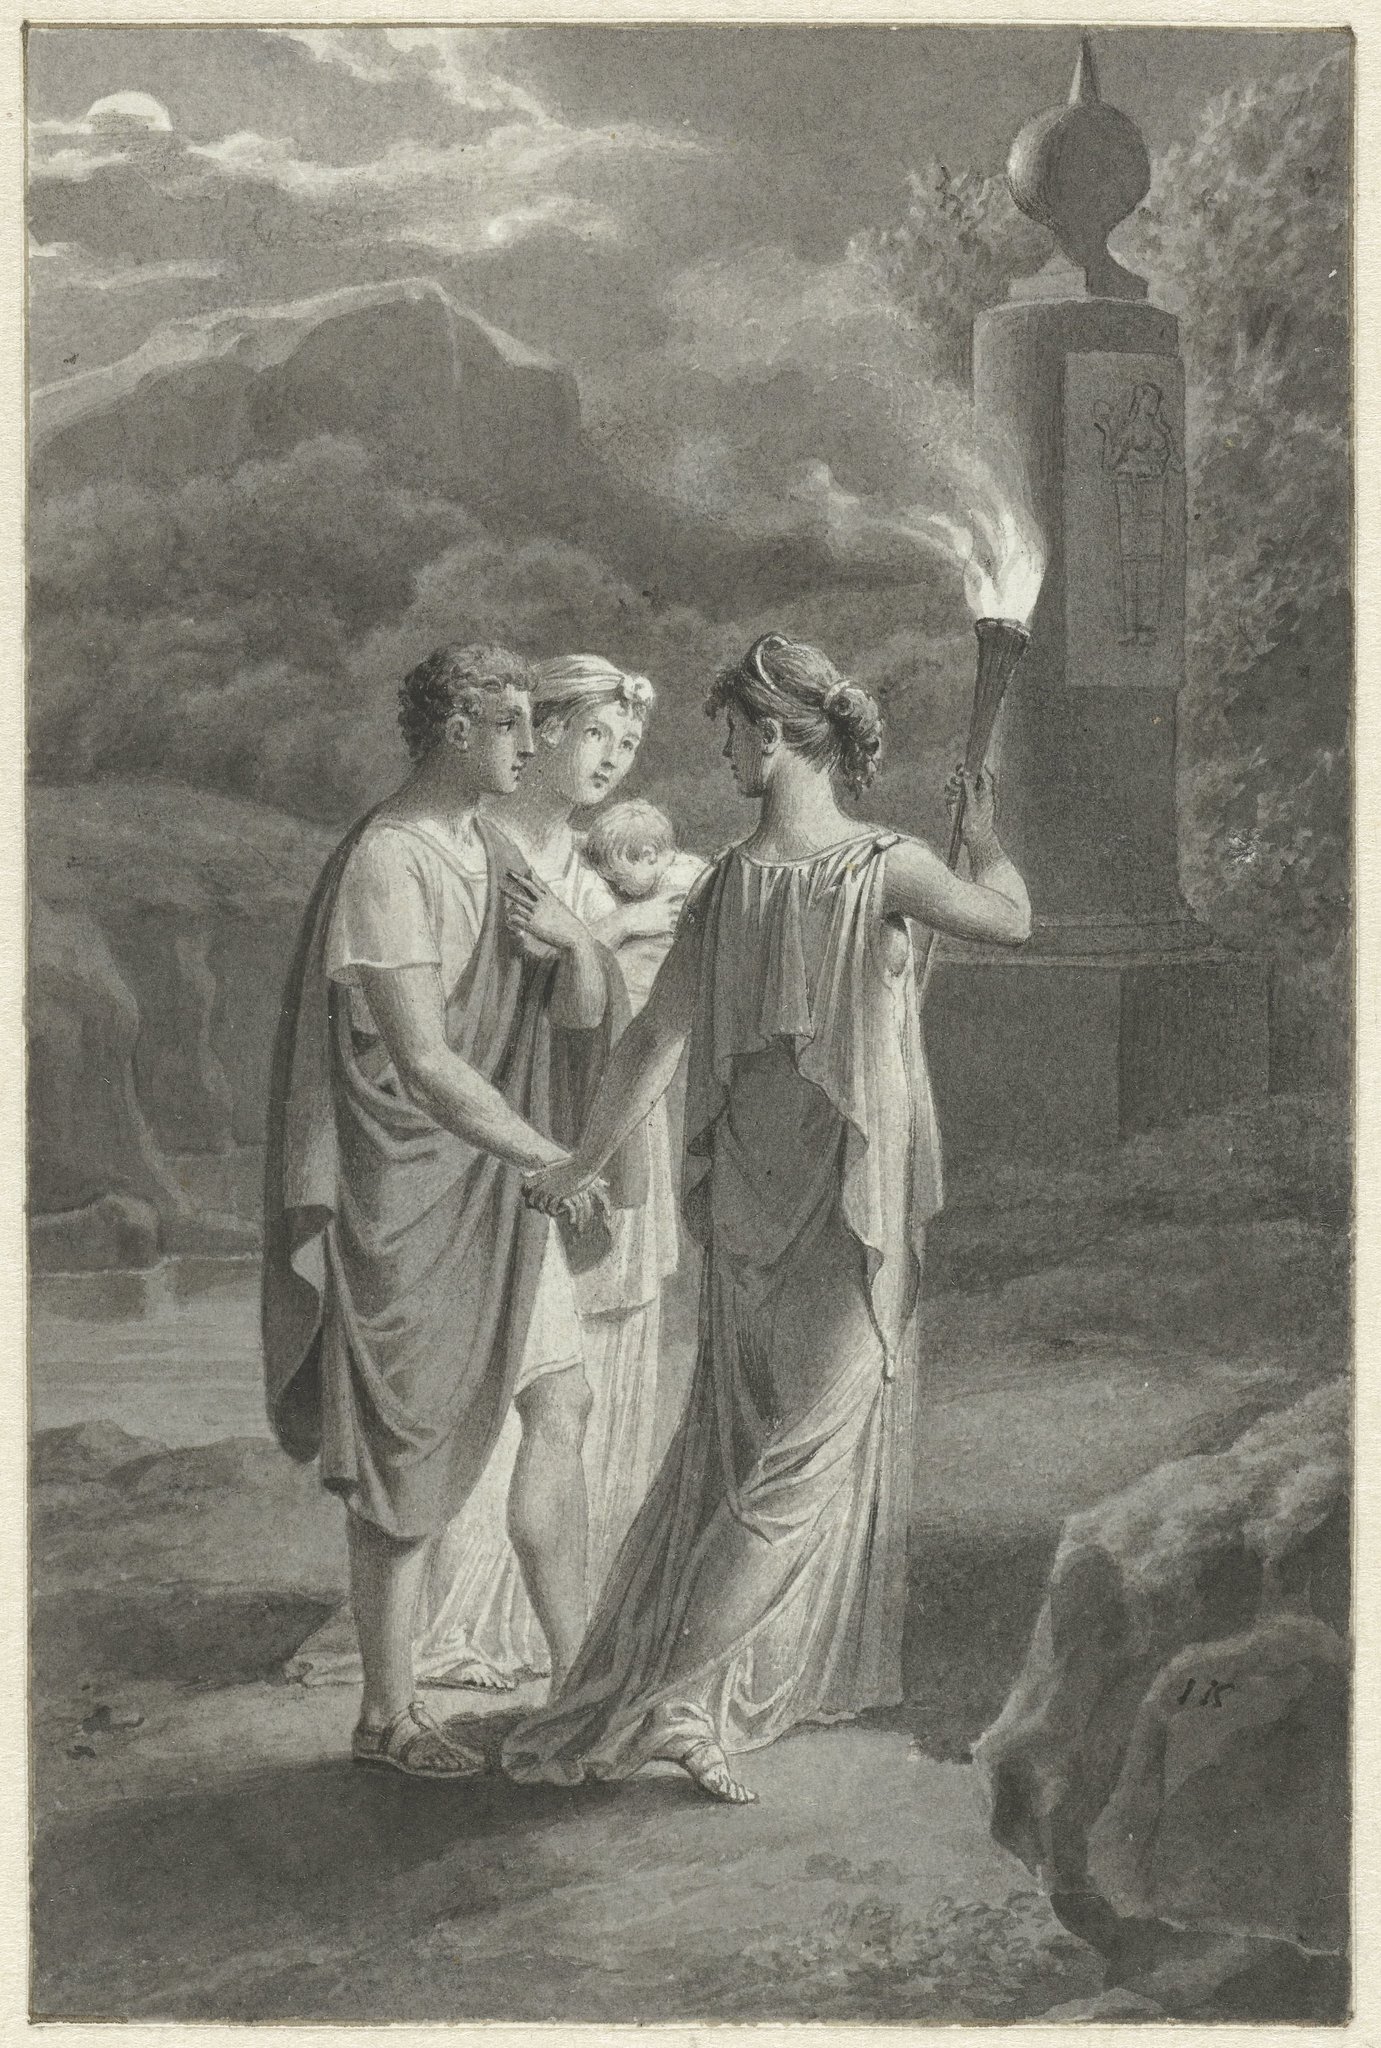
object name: drawing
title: Ontwerp voor een boekillustratie met een jong gezin en een vrouw met een fakkel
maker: jacques kuyper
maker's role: draughtsman, print maker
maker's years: 1761-1808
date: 1771-1808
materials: ink, paper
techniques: brush, pen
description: Ontwerp voor een boekillustratie: jong gezin en vrouw met fakkel in nachtlandschap. Ontwerp voor een prent.